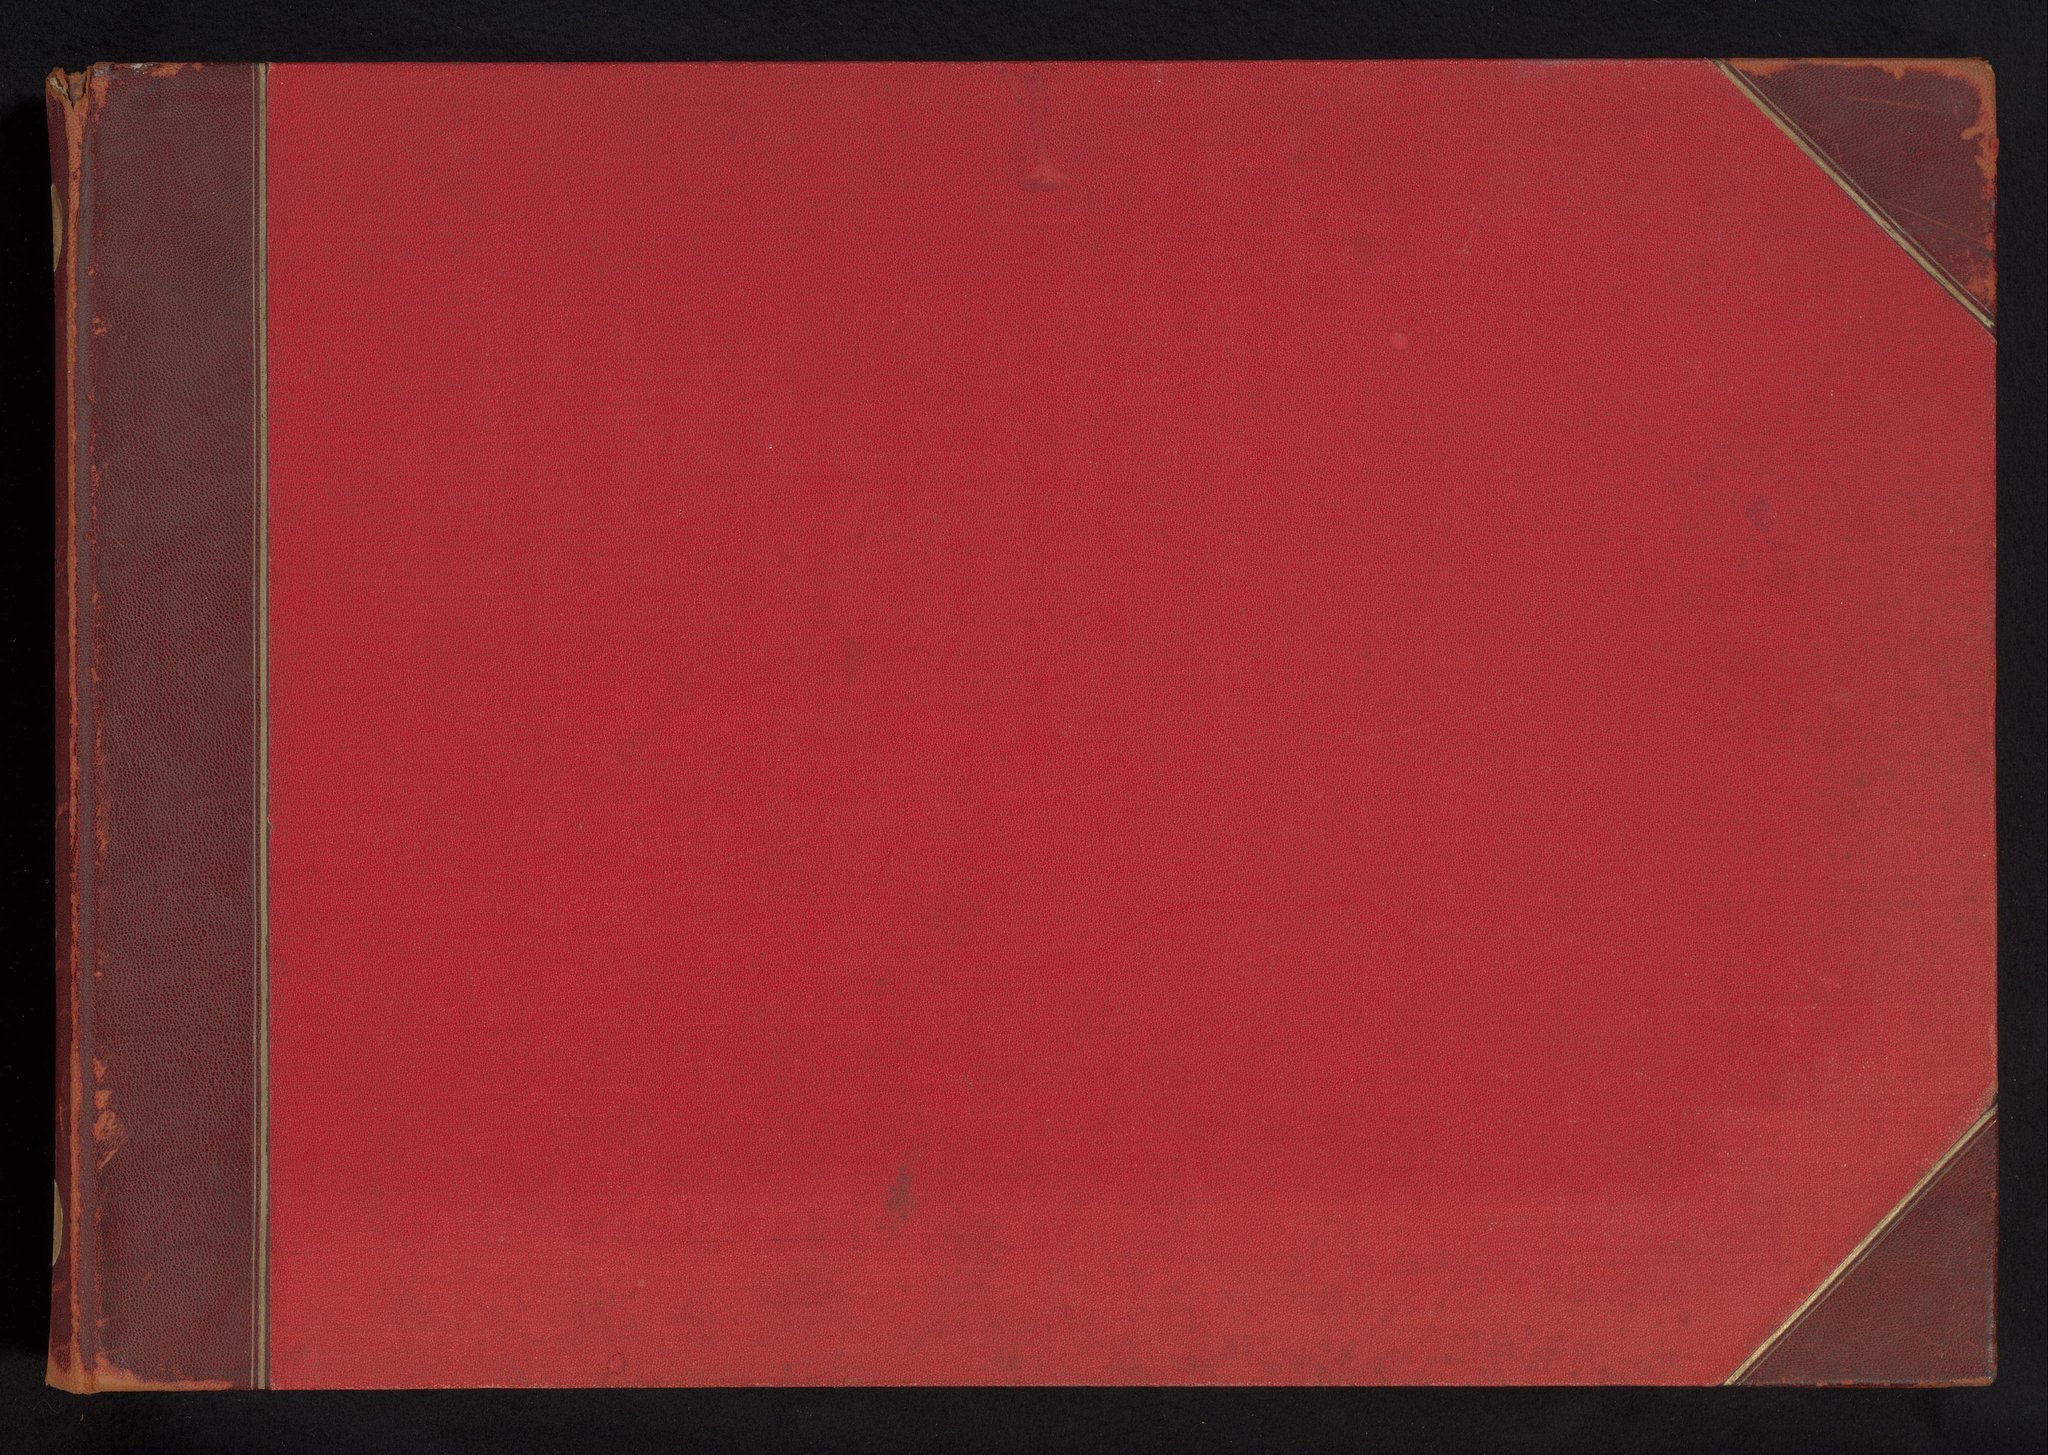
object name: scrapbook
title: Fotoalbum met 57 foto's van kunstwerken, voornamelijk in het Vaticaan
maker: Anonymous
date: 1857-1920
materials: cardboard, leather, paper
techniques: albumen print, gelatin silver print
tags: piece of sculpture, reproduction of a piece of sculpture, picture, painting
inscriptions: inscription: ‘AH/ 621/ Z/ 4’, inscription: ‘54 foto's/ HL’, inscription: ‘Technische Hoogeschool/ Afd./ BOETSEEREN.’, inscription: ‘AH 621/ Z 4/ G 362’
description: Plakboek met 57 foto's van kunstwerken in de Vaticaanse Musea, de Glyptothek München en van paus Pius X in Lourdes. Het merendeel van de foto's bevat afgedrukte titels op object in het Italiaans. Het album bevat 42 albuminedrukken, negen ontwikkelgelatinezilverdrukken, vijf daglichtgelatinezilverdrukken en één daglichtcollodiumdruk. 33 foto's zijn vervaardigd door James Anderson, twaalf door de Fratelli Alinari en de rest door andere of anonieme fotografen. De laatste drie pagina's van het album zijn leeg. Het album was eigendom van de Technische Hoogeschool.